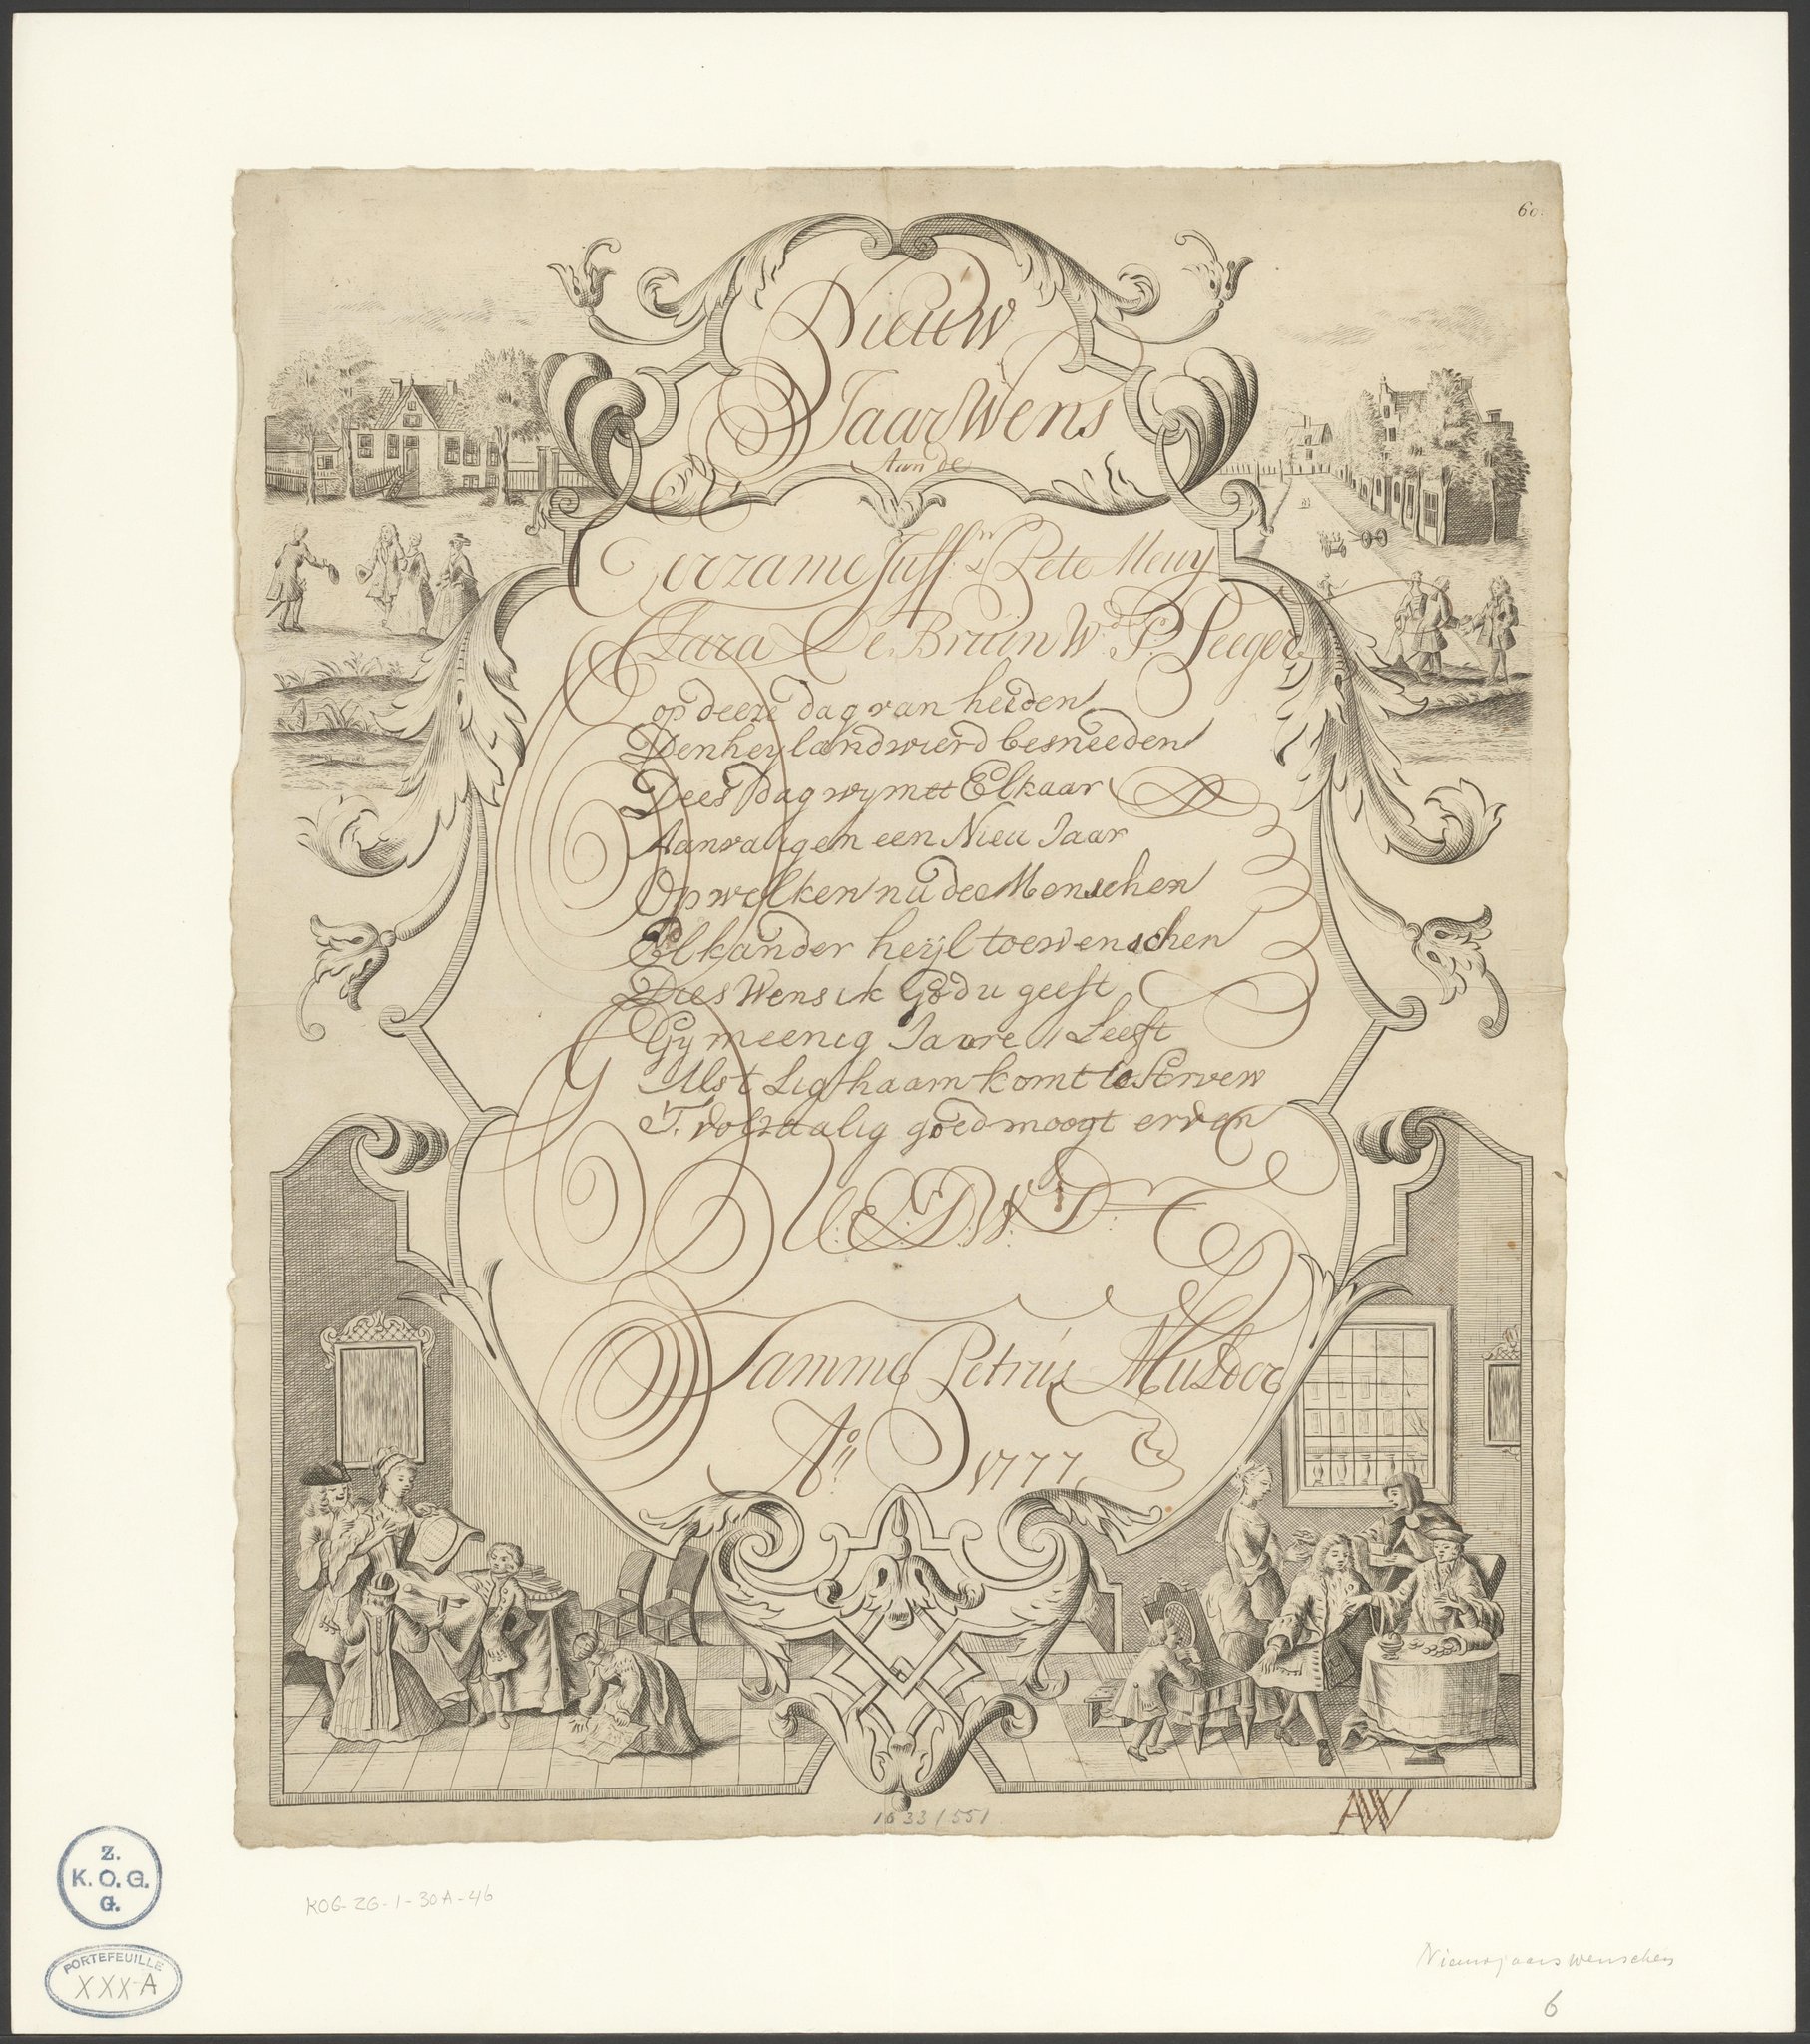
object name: wensbrief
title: Nieuwjaarswens door Tamme Petrus Mulder, 1777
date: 1777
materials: ink, paper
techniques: engraving, handwriting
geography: netherlands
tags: january 1 (~ festivities), family life at home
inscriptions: collector's mark, collector's mark: Lugt 1641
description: Nieuwjaarswens door Tamme Petrus Mulder, 1777. Gericht aan zijn 'pete meuy'. Vers geschreven op een voorgedrukt blad met een kader gevormd door scènes uit het familieleven, binnen en op straat. Genummerd rechtsboven: 60. Onderwerpsrubrieken binnen de Atlas Zeden en Gewoonten: Nieuwjaars- en kermiswenschen.